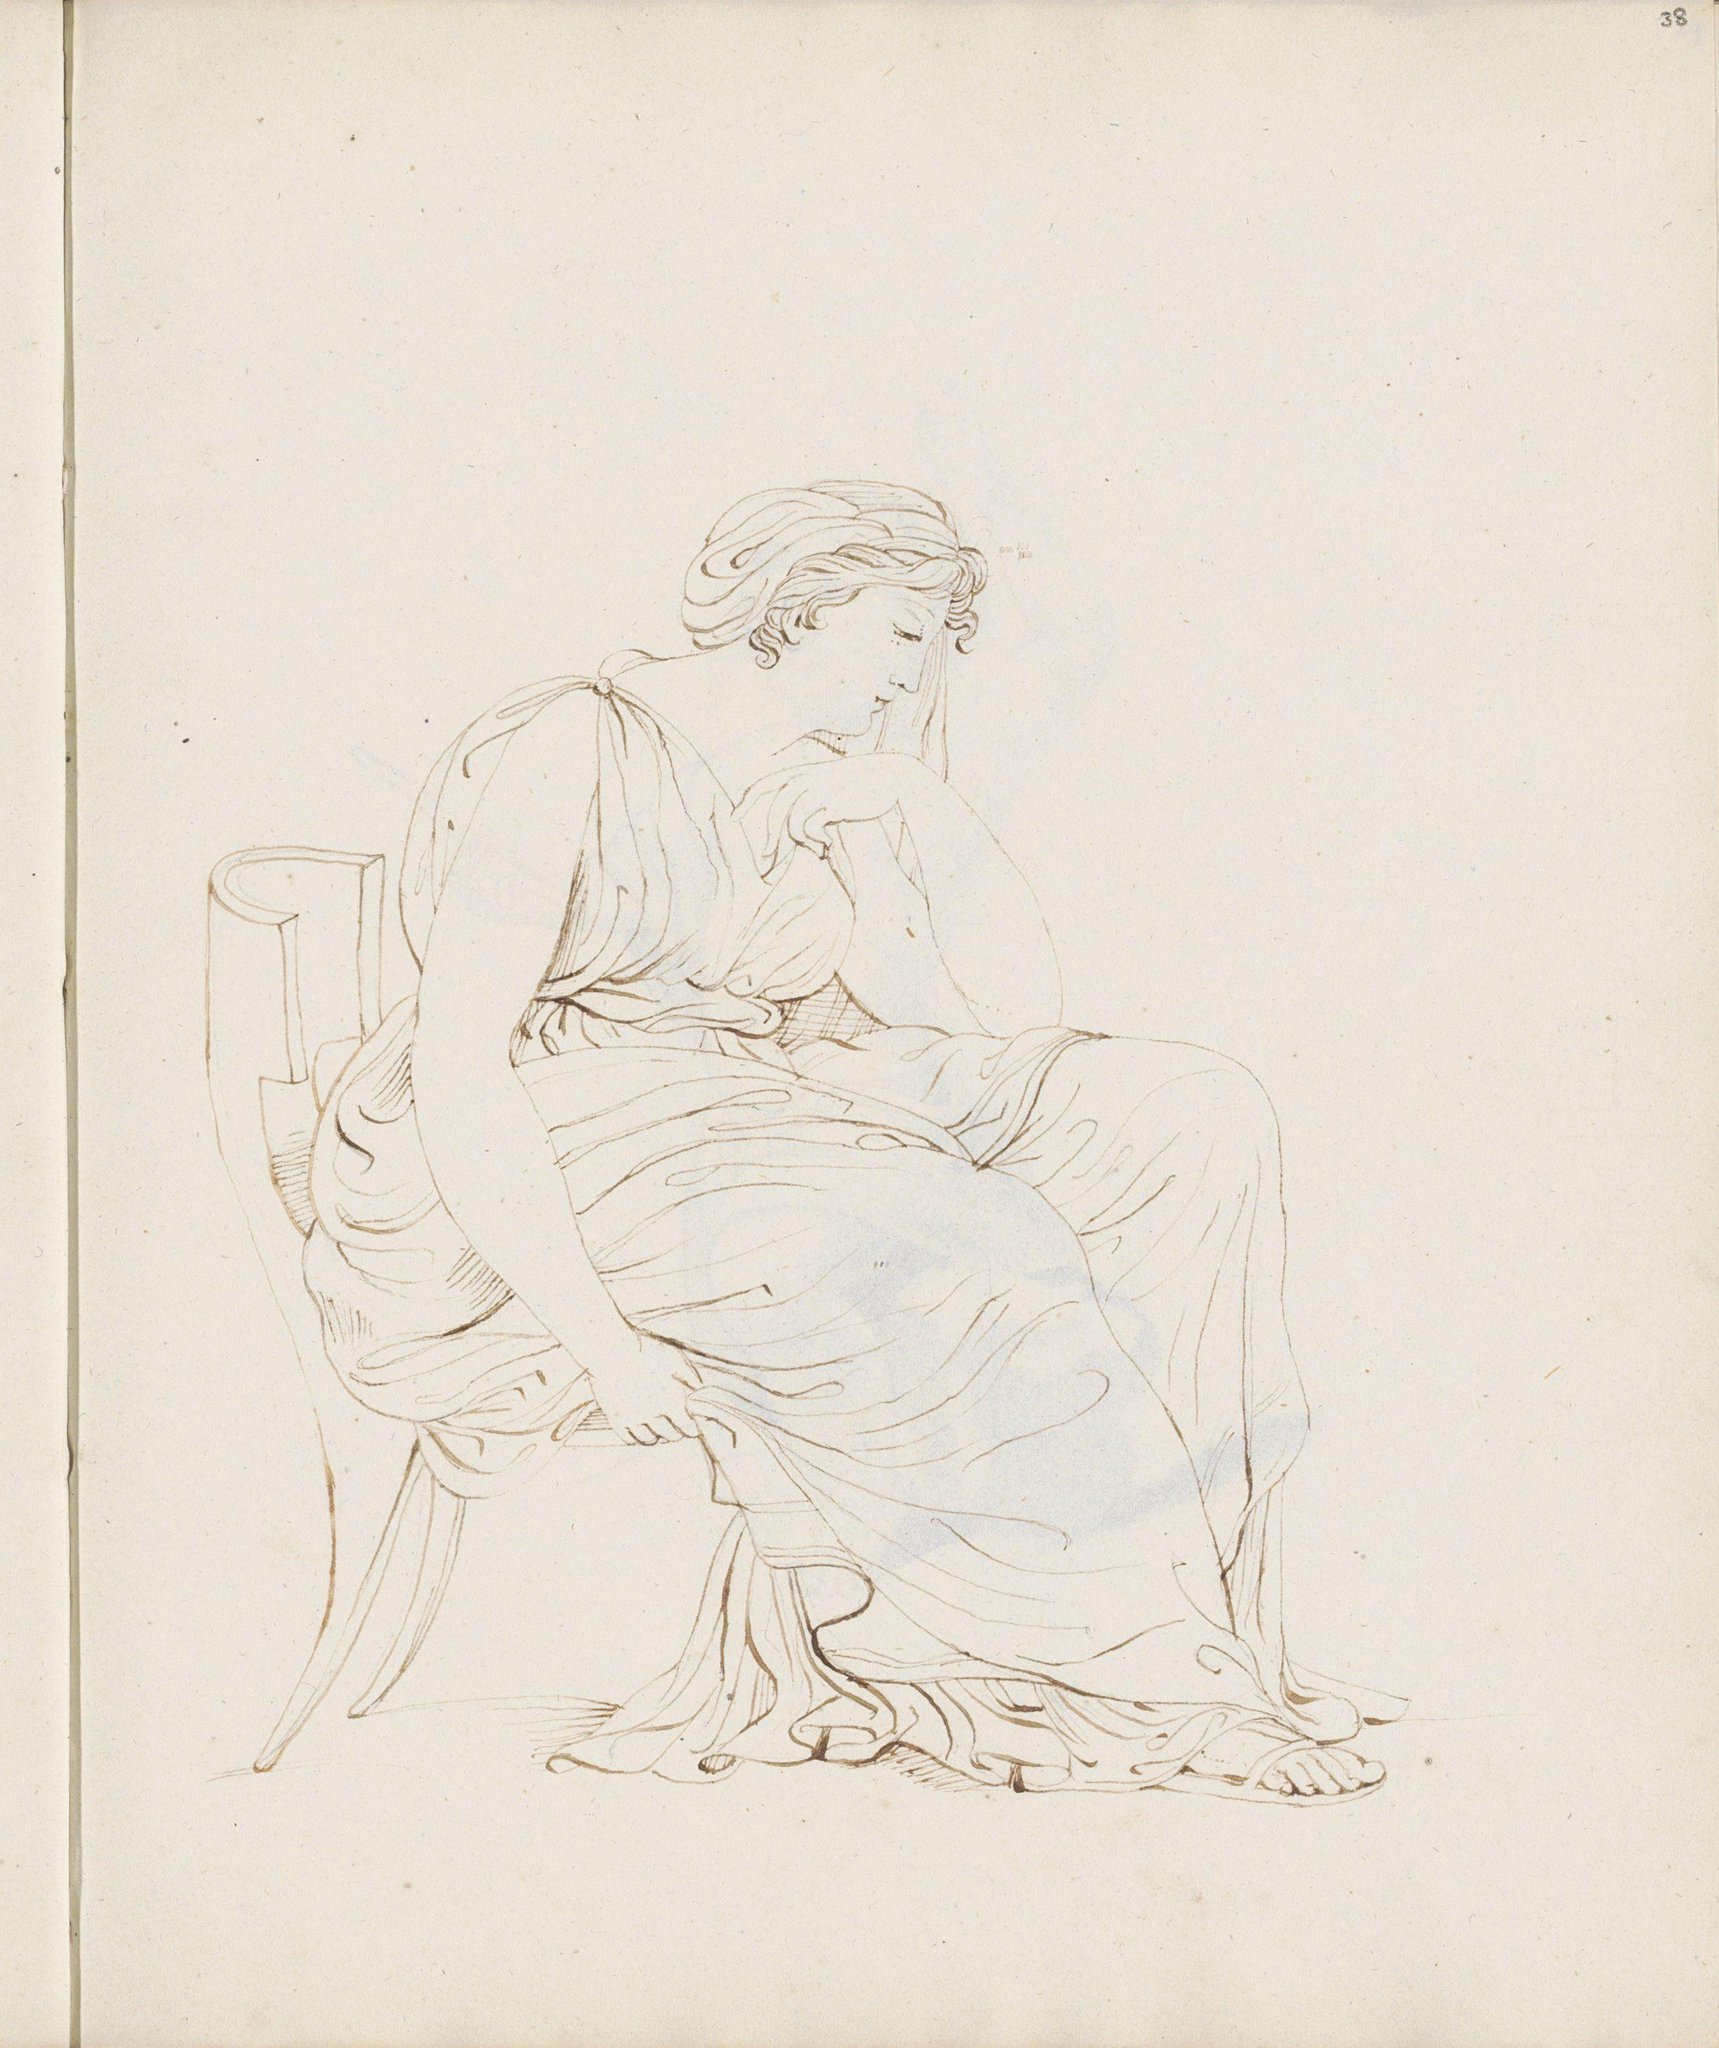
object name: sketchbook leaf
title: Zittende vrouw in een treurende houding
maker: jonkvrouw catharina kemper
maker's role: draughtsman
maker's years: 1801-1871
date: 1813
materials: ink, paper, pencil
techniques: pen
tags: sitting figure - aa - female human figure, the sorrowing penelope, classical mythology and ancient history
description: De vrouw draagt een tuniek en zit met het hoofd licht voorovergebogen. Mogelijk de treurende Penelope. Vermoedelijk getekend naar klassiek voorbeeld. Blad 38 recto uit een schetsboek met 91 bladen.